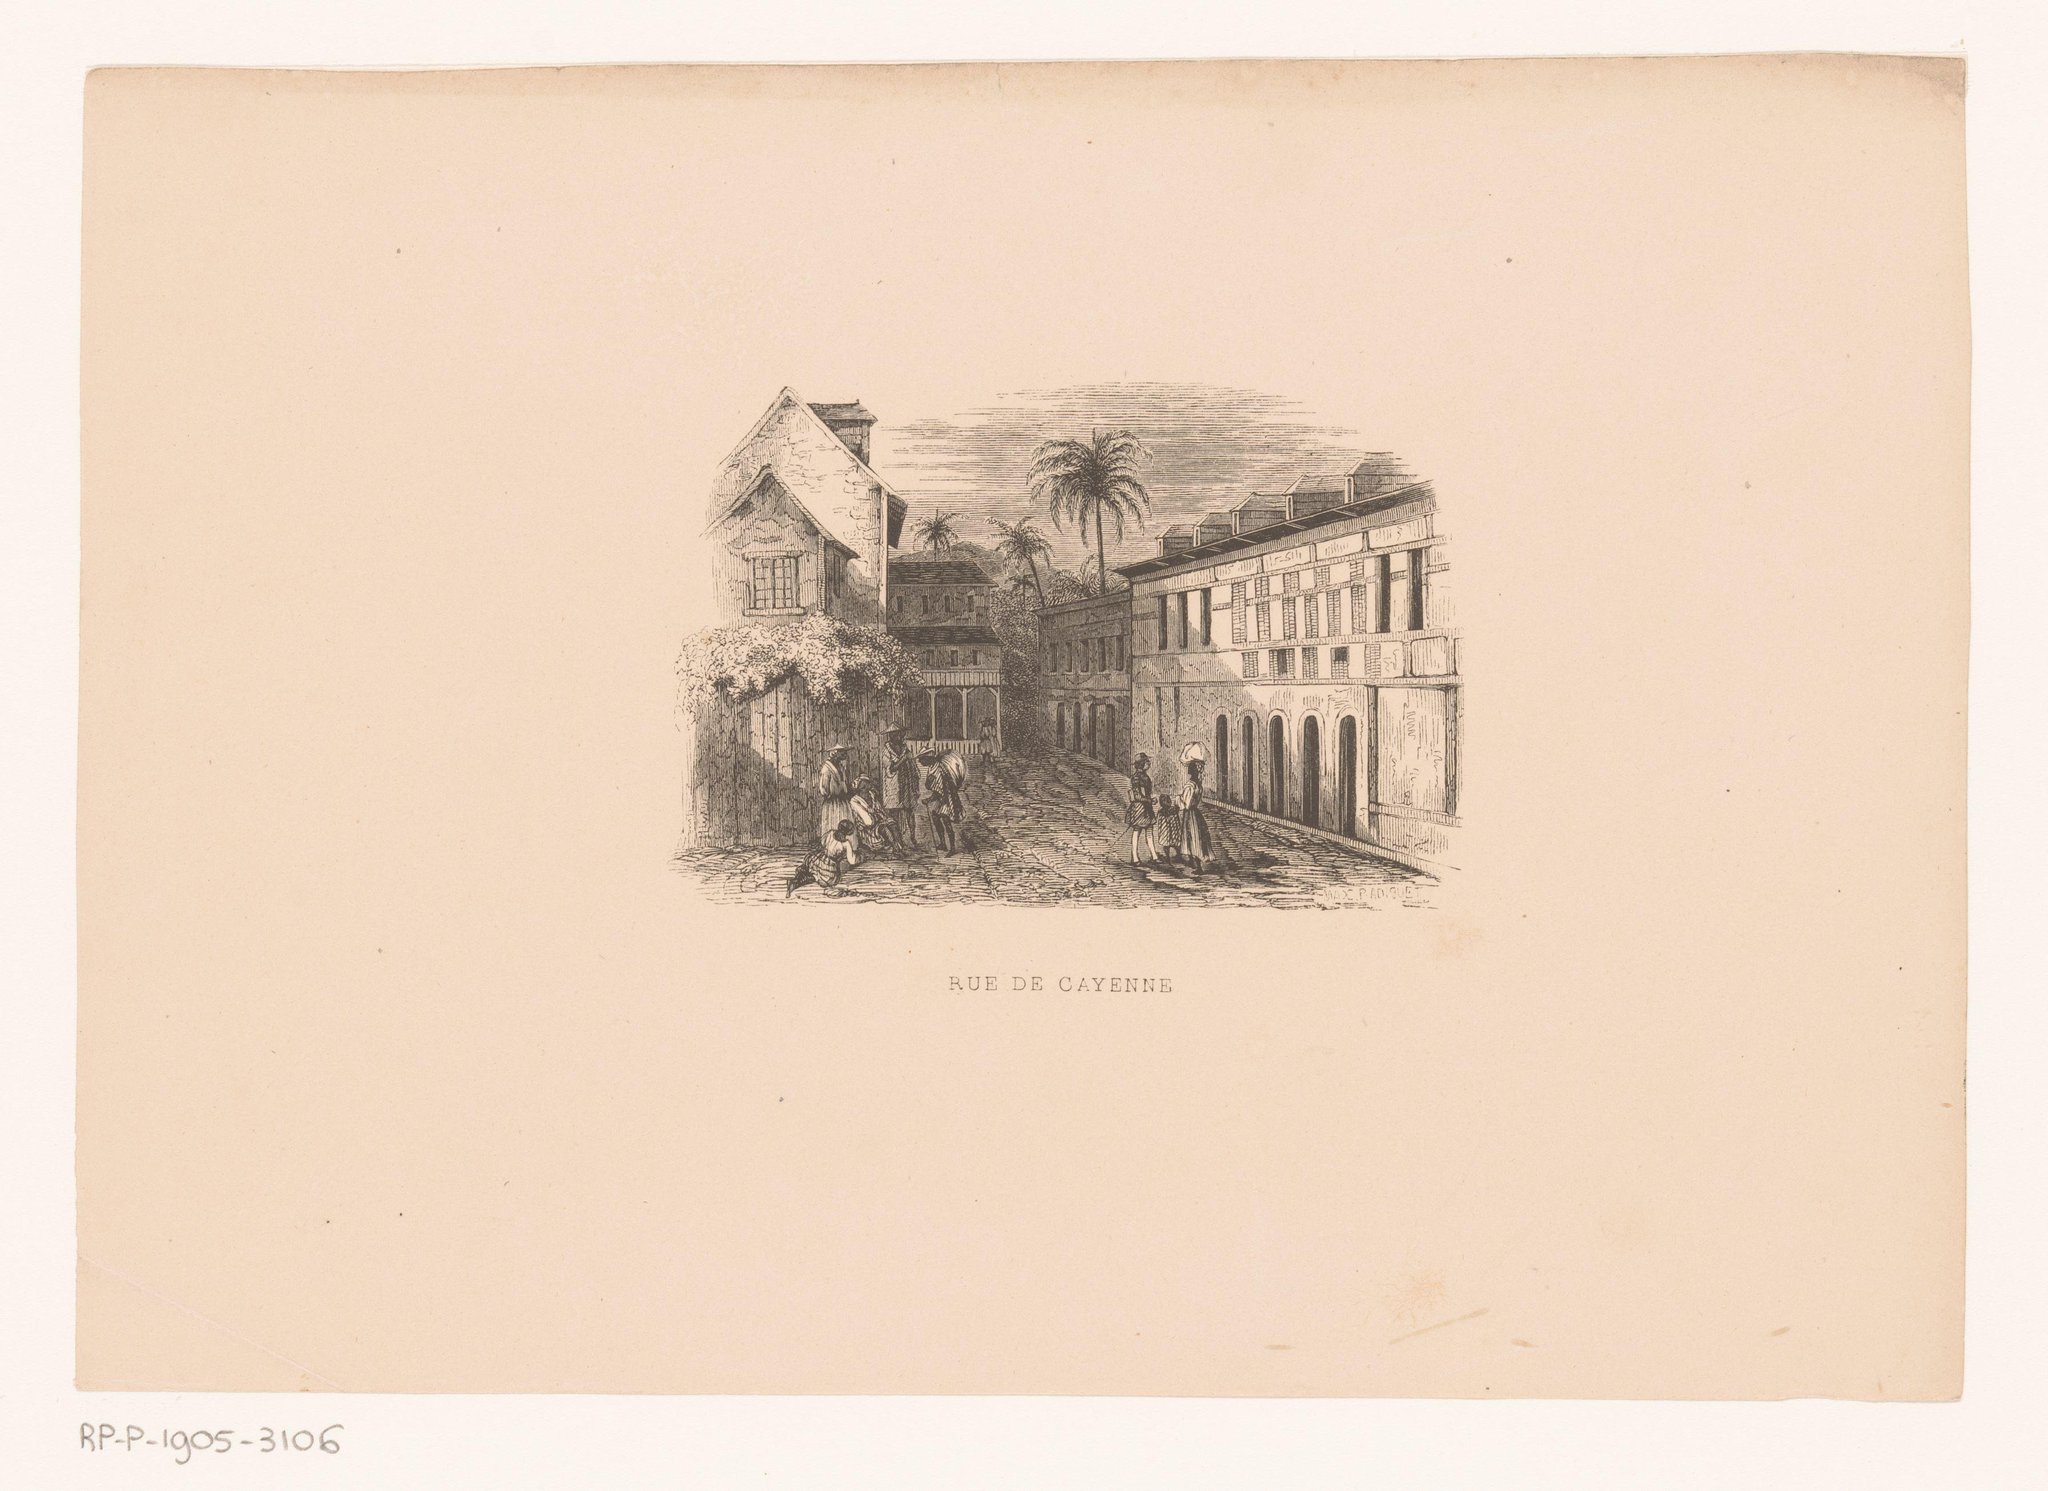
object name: print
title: Gezicht op de Rue de Cayenne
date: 1841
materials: paper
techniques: engraving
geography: paris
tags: city-view, and landscape with man-made constructions, trees: palm-tree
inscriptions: collector's mark: Lugt 2228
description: Prent uit: Les Français peints par eux-mêmes. Parijs: Leon Curmer, 1841.